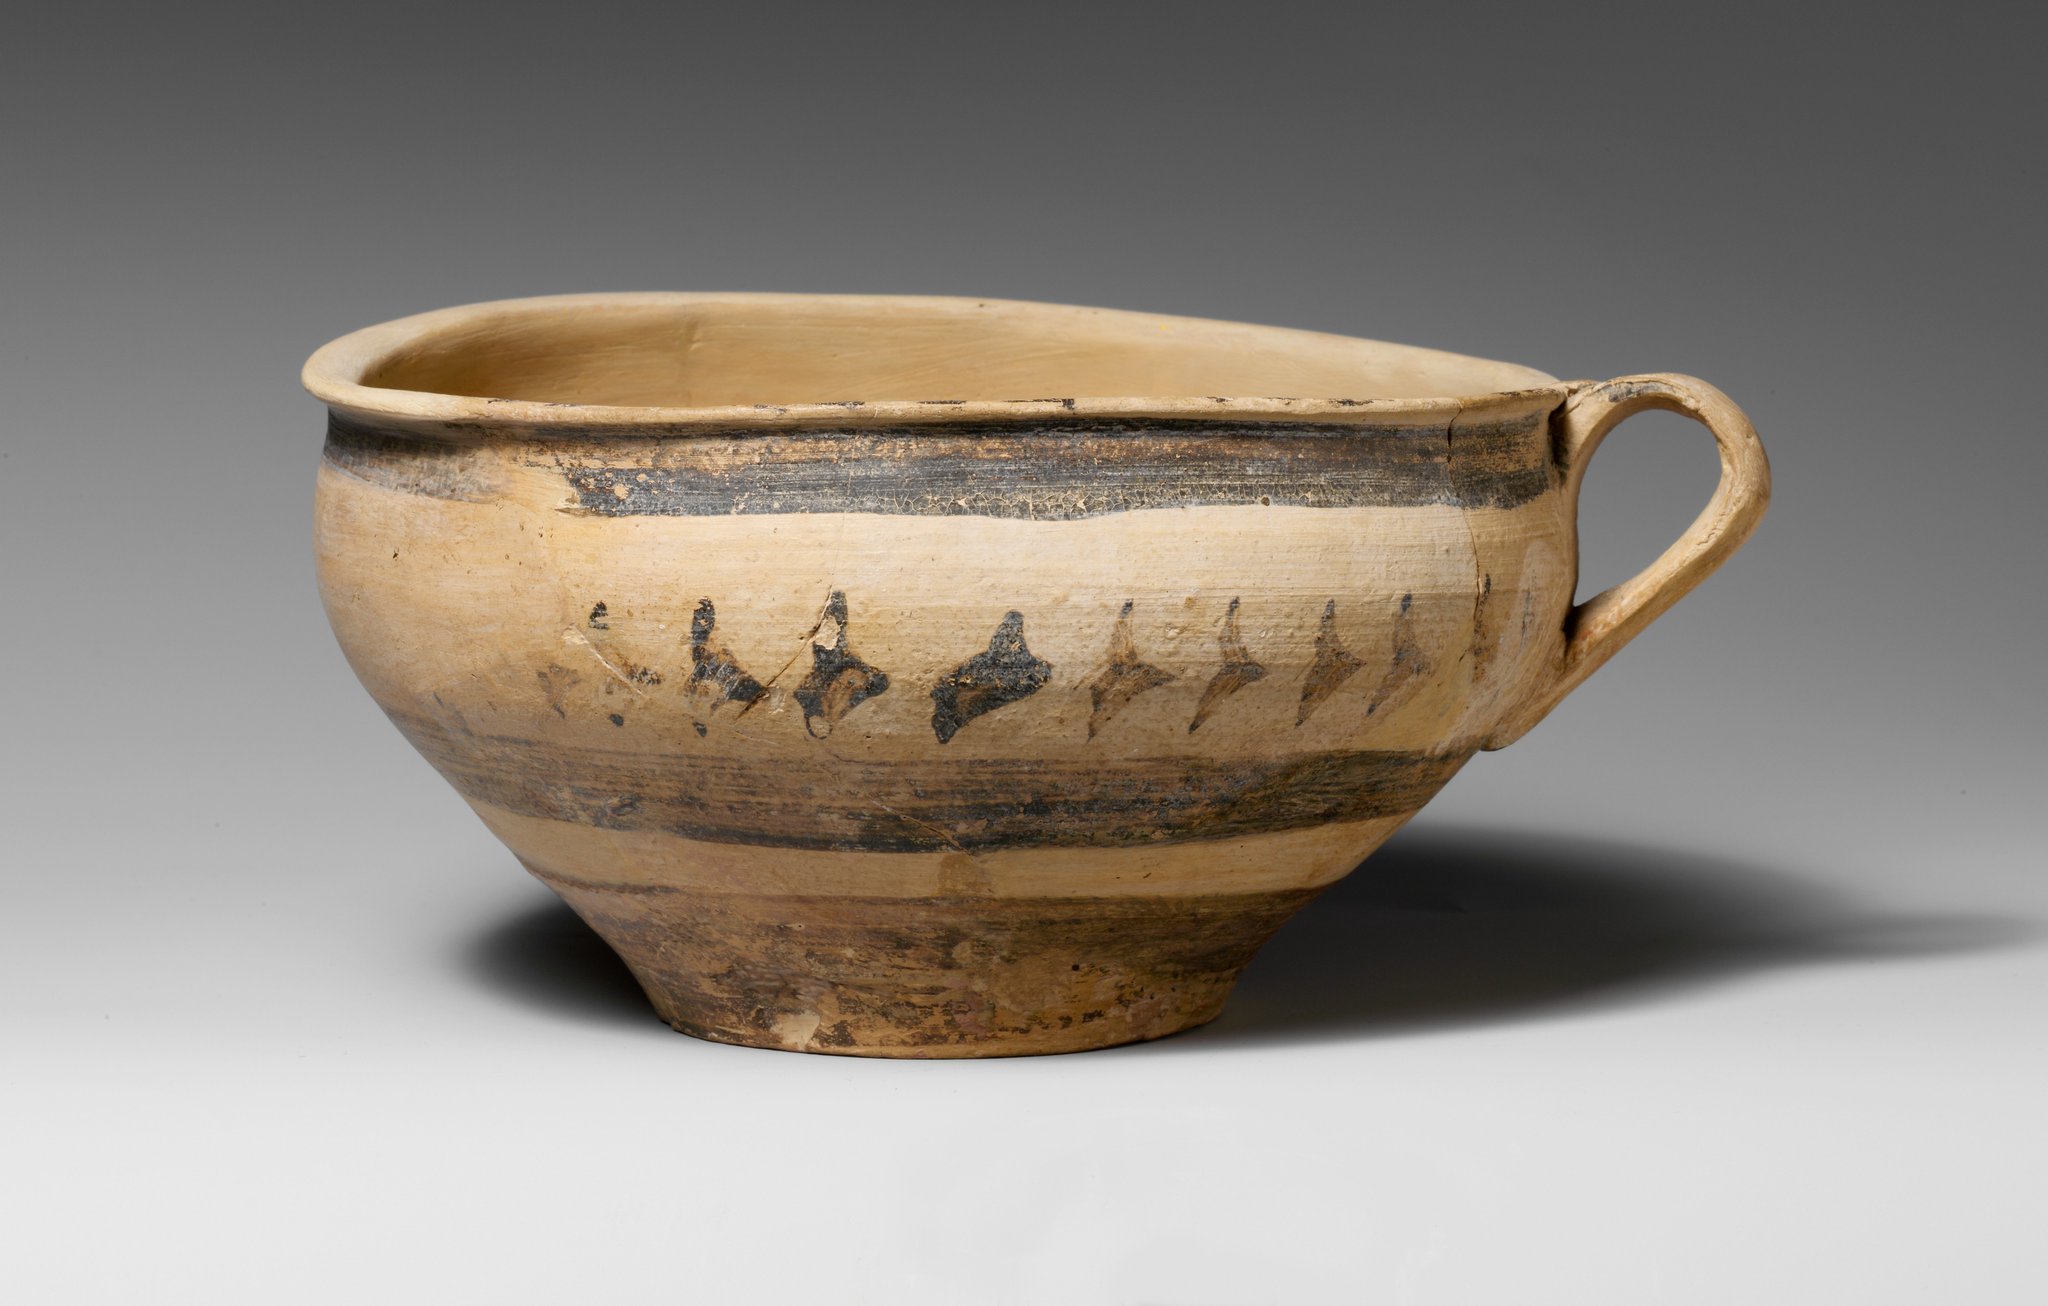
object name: cup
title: Terracotta one-handled cup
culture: minoan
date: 1600-1450 BCE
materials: terracotta